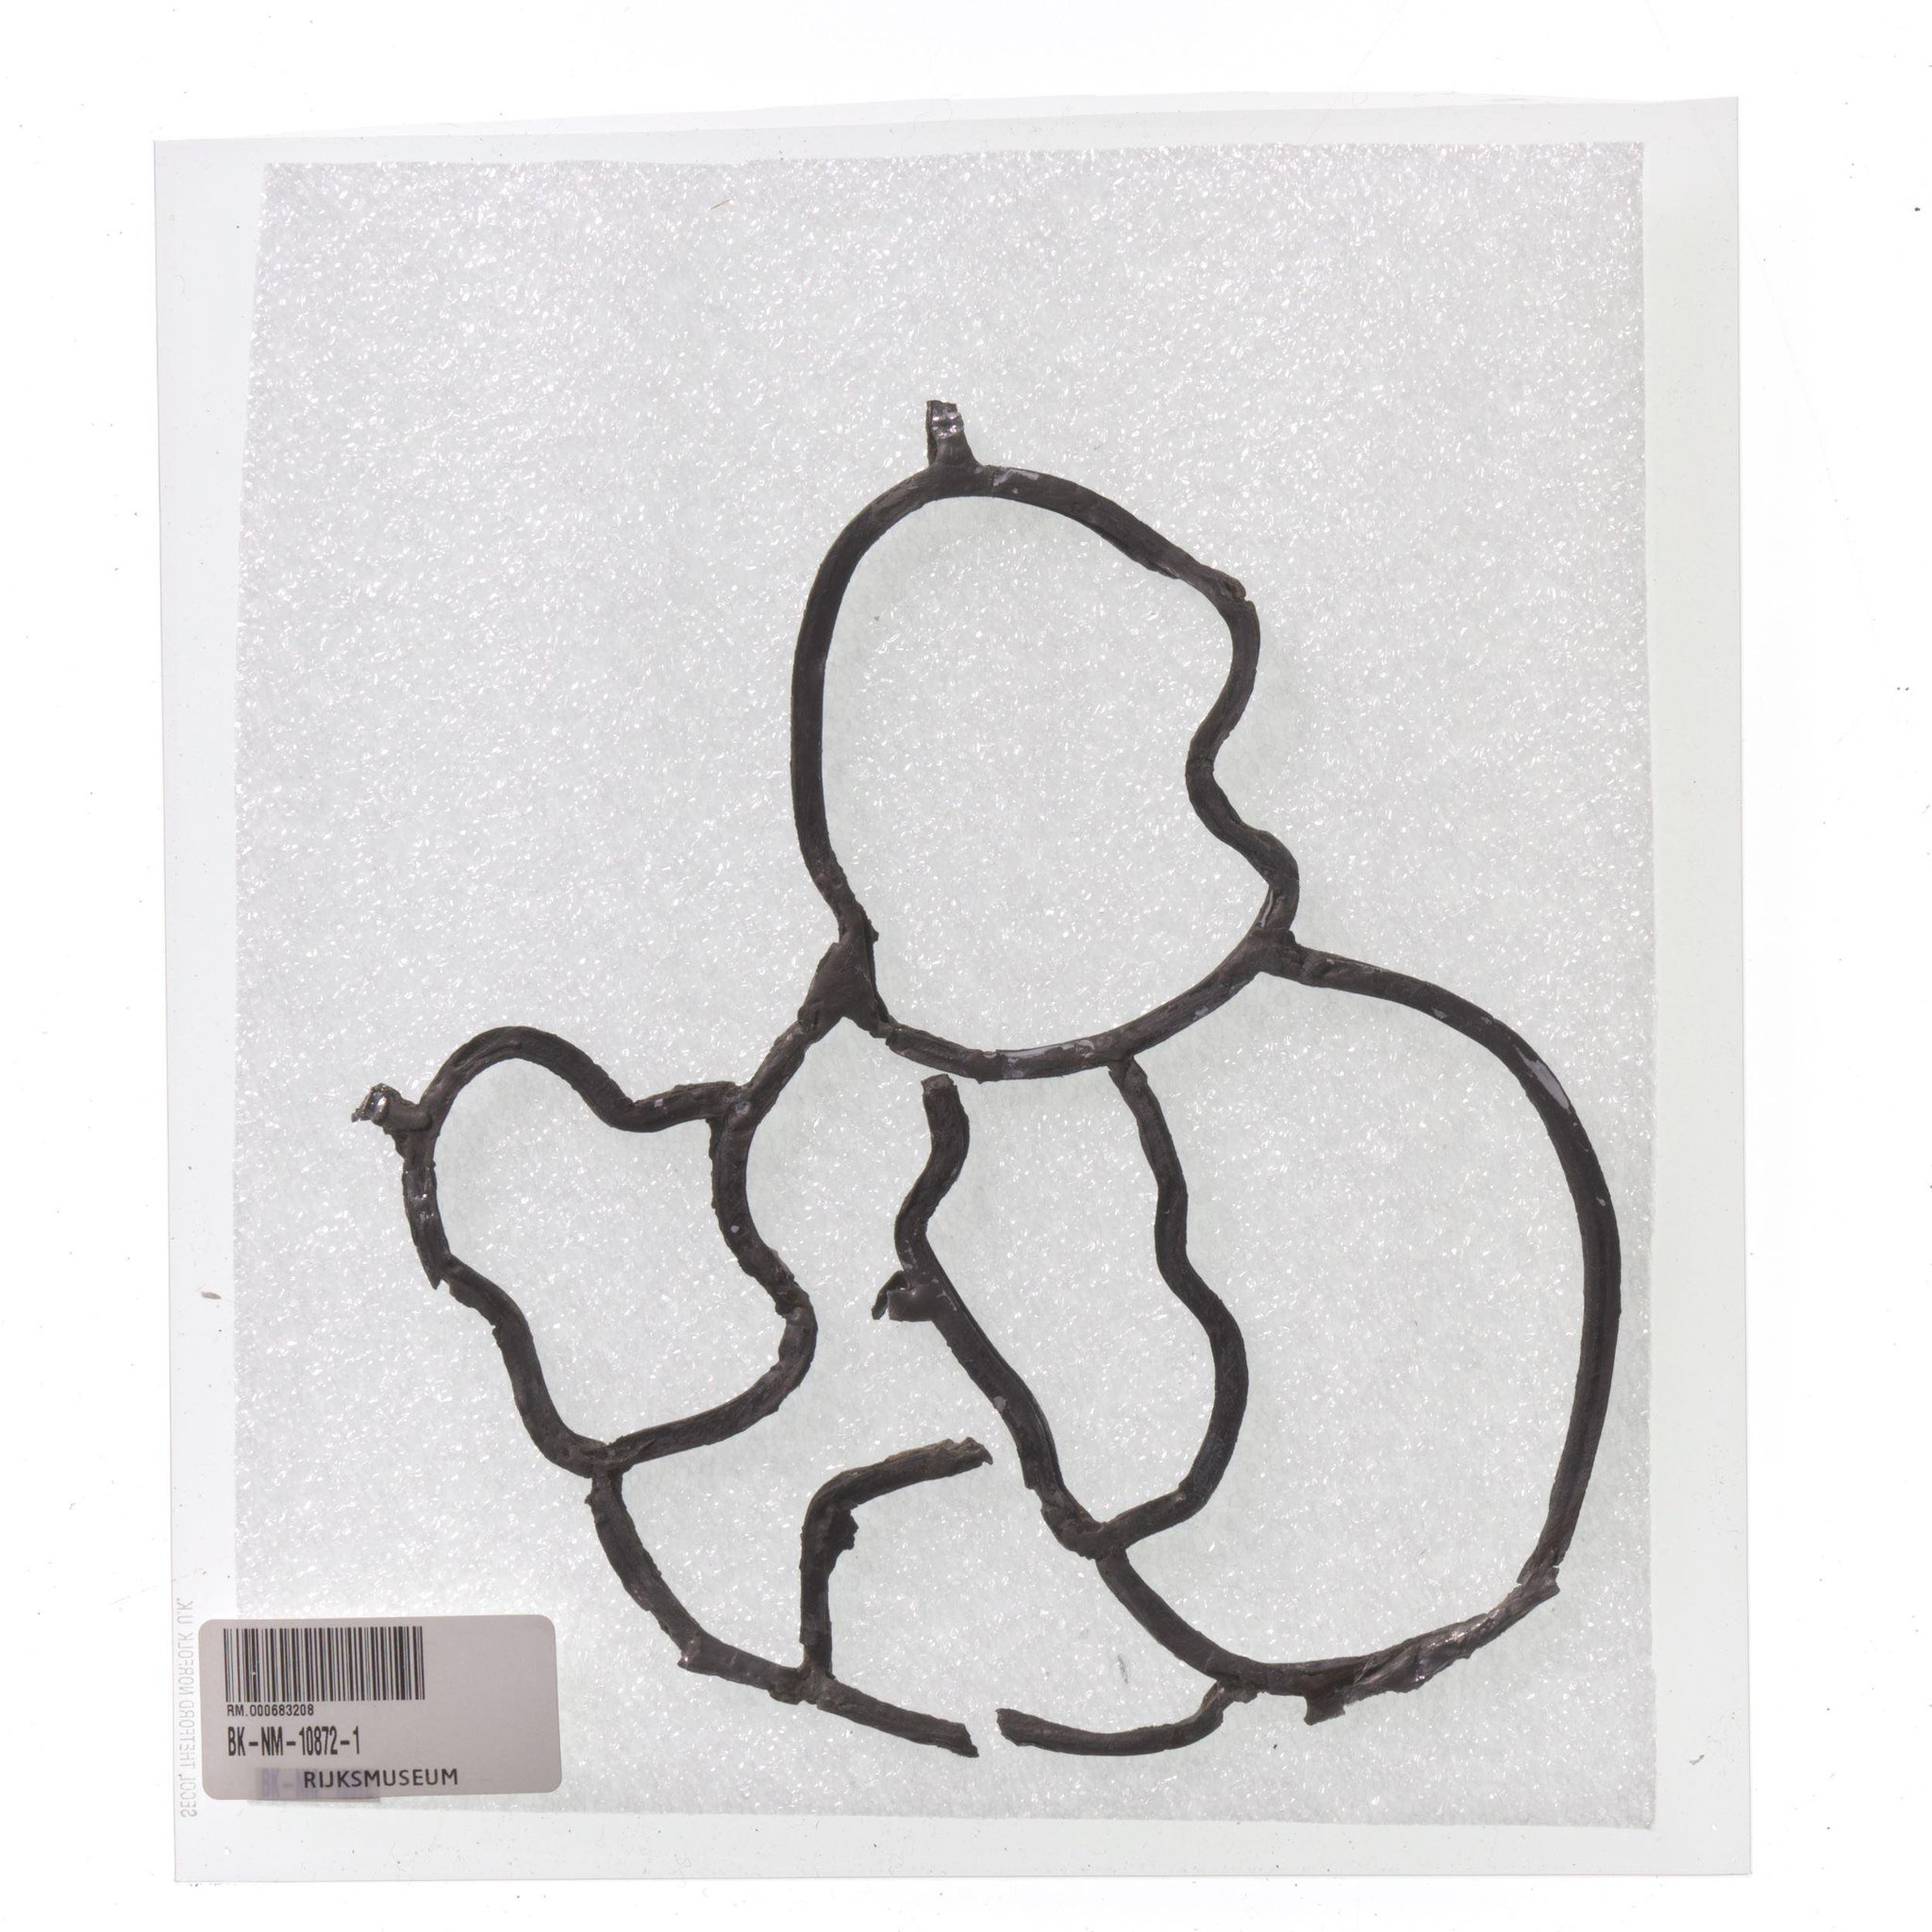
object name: light window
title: Lood van de ruit van gebrandschilderd glas met de buste van een manspersoon in biddende houding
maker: Anonymous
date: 1400-1450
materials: lead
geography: southern netherlands